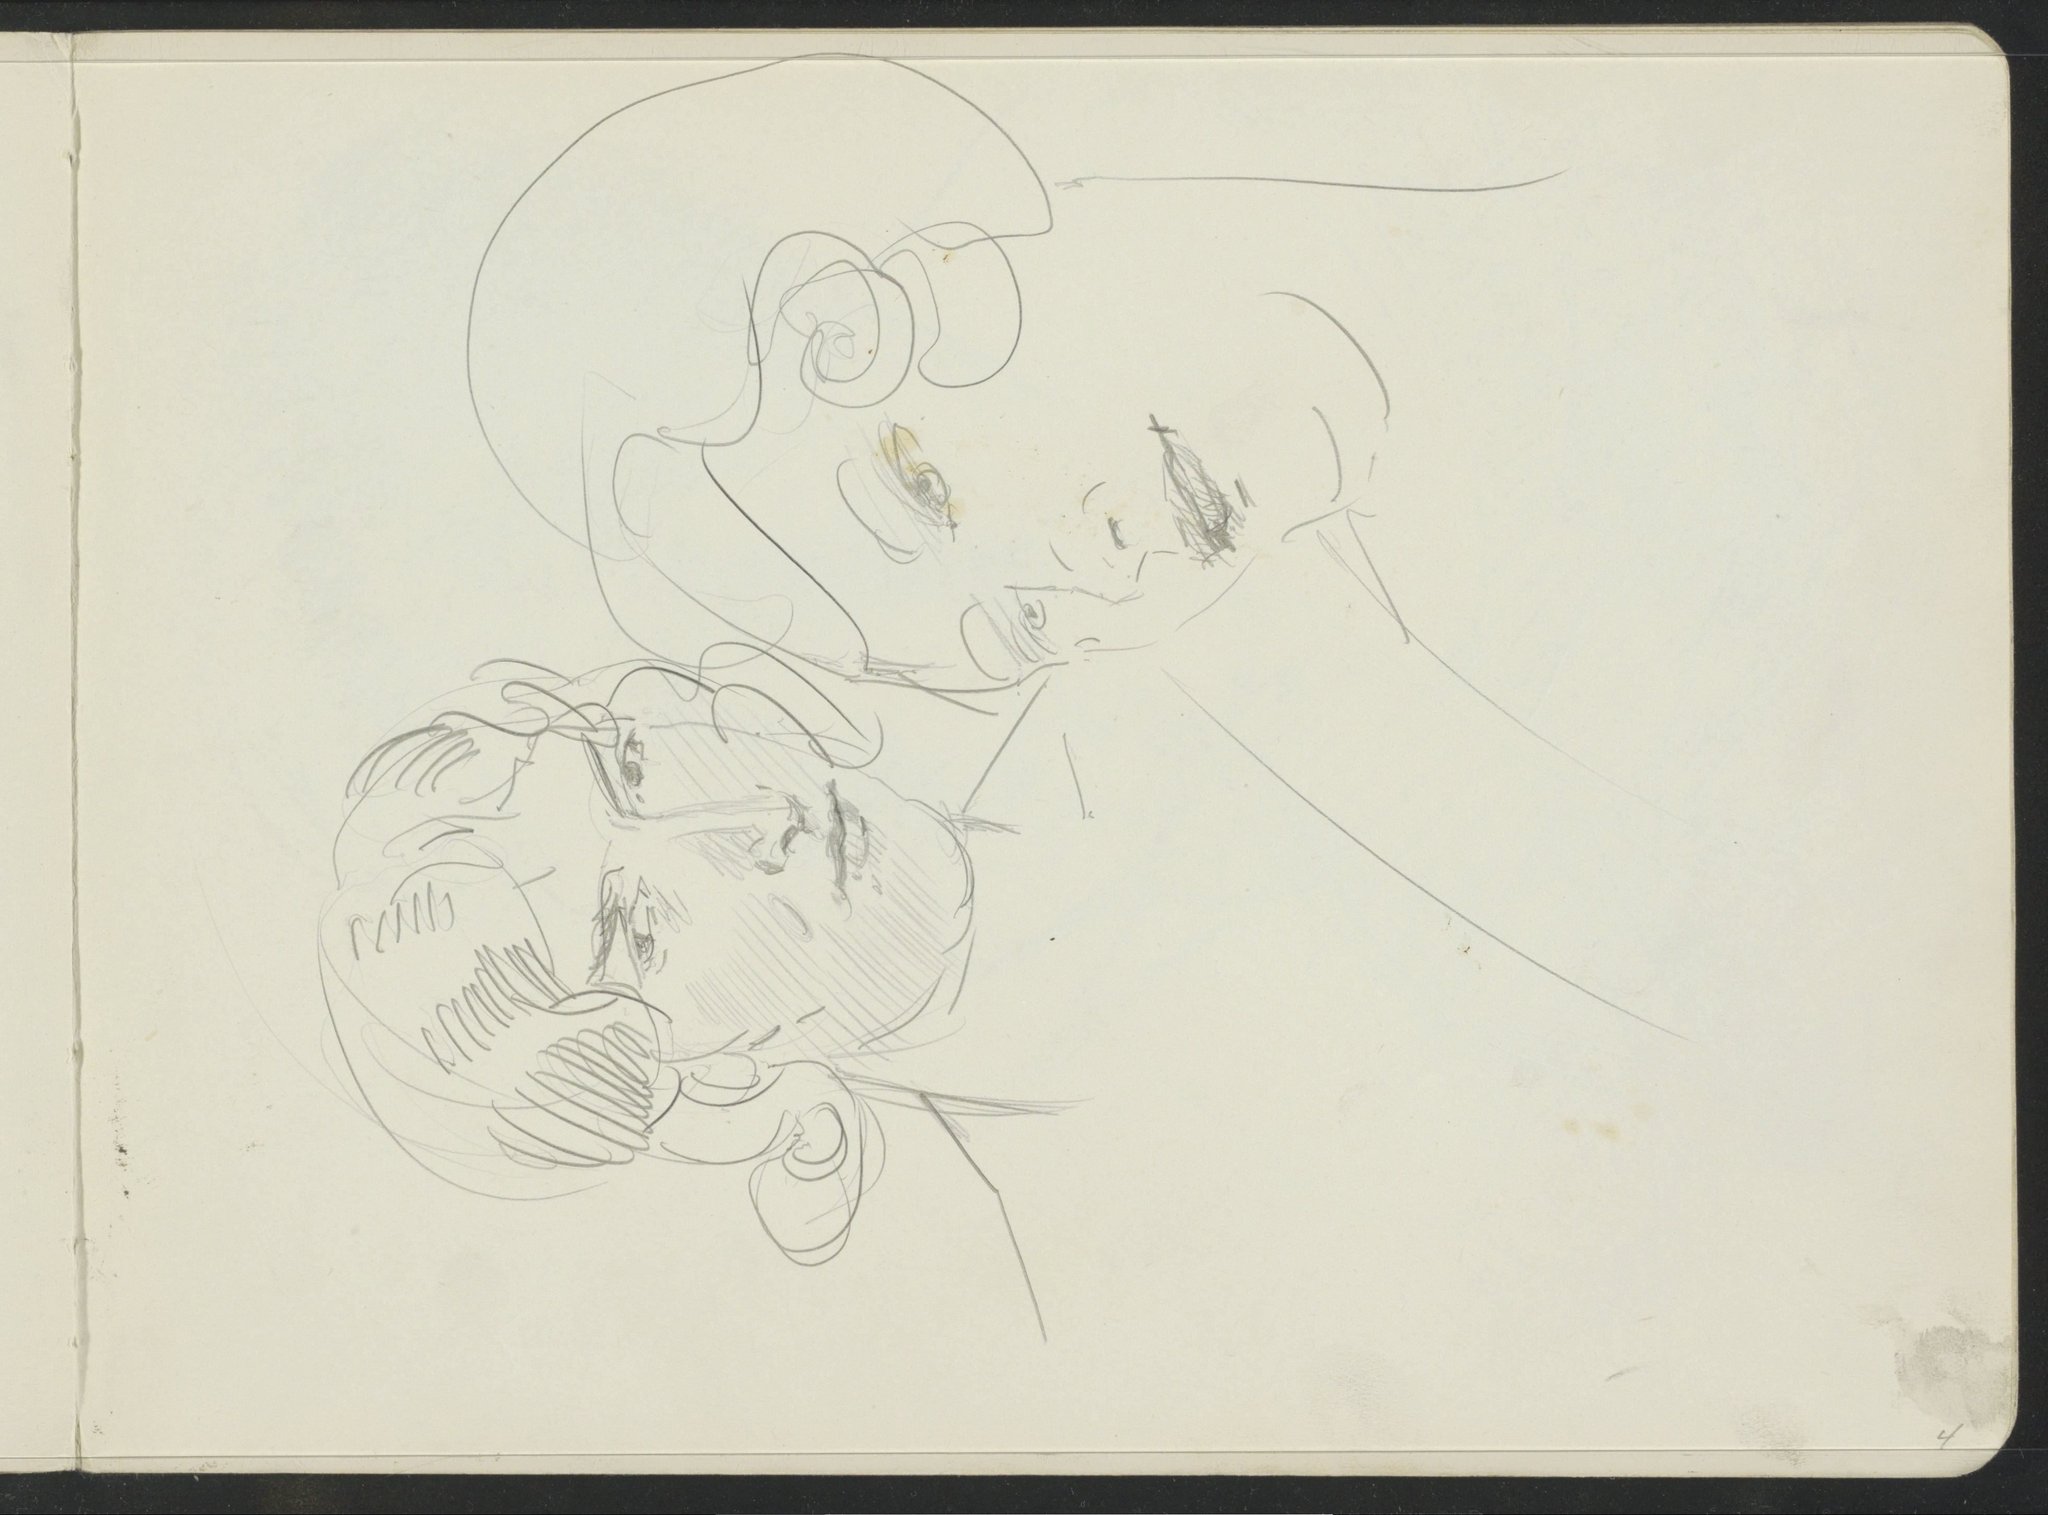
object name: sketchbook leaf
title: Twee vrouwenhoofden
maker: isaac israels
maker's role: draughtsman, painter, print maker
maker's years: 1865-1934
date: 1915-1934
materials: paper, pencil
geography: the hague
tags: head (human) - aa - female human figure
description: Blad 4 recto uit schetsboek XV met 22 bladen.